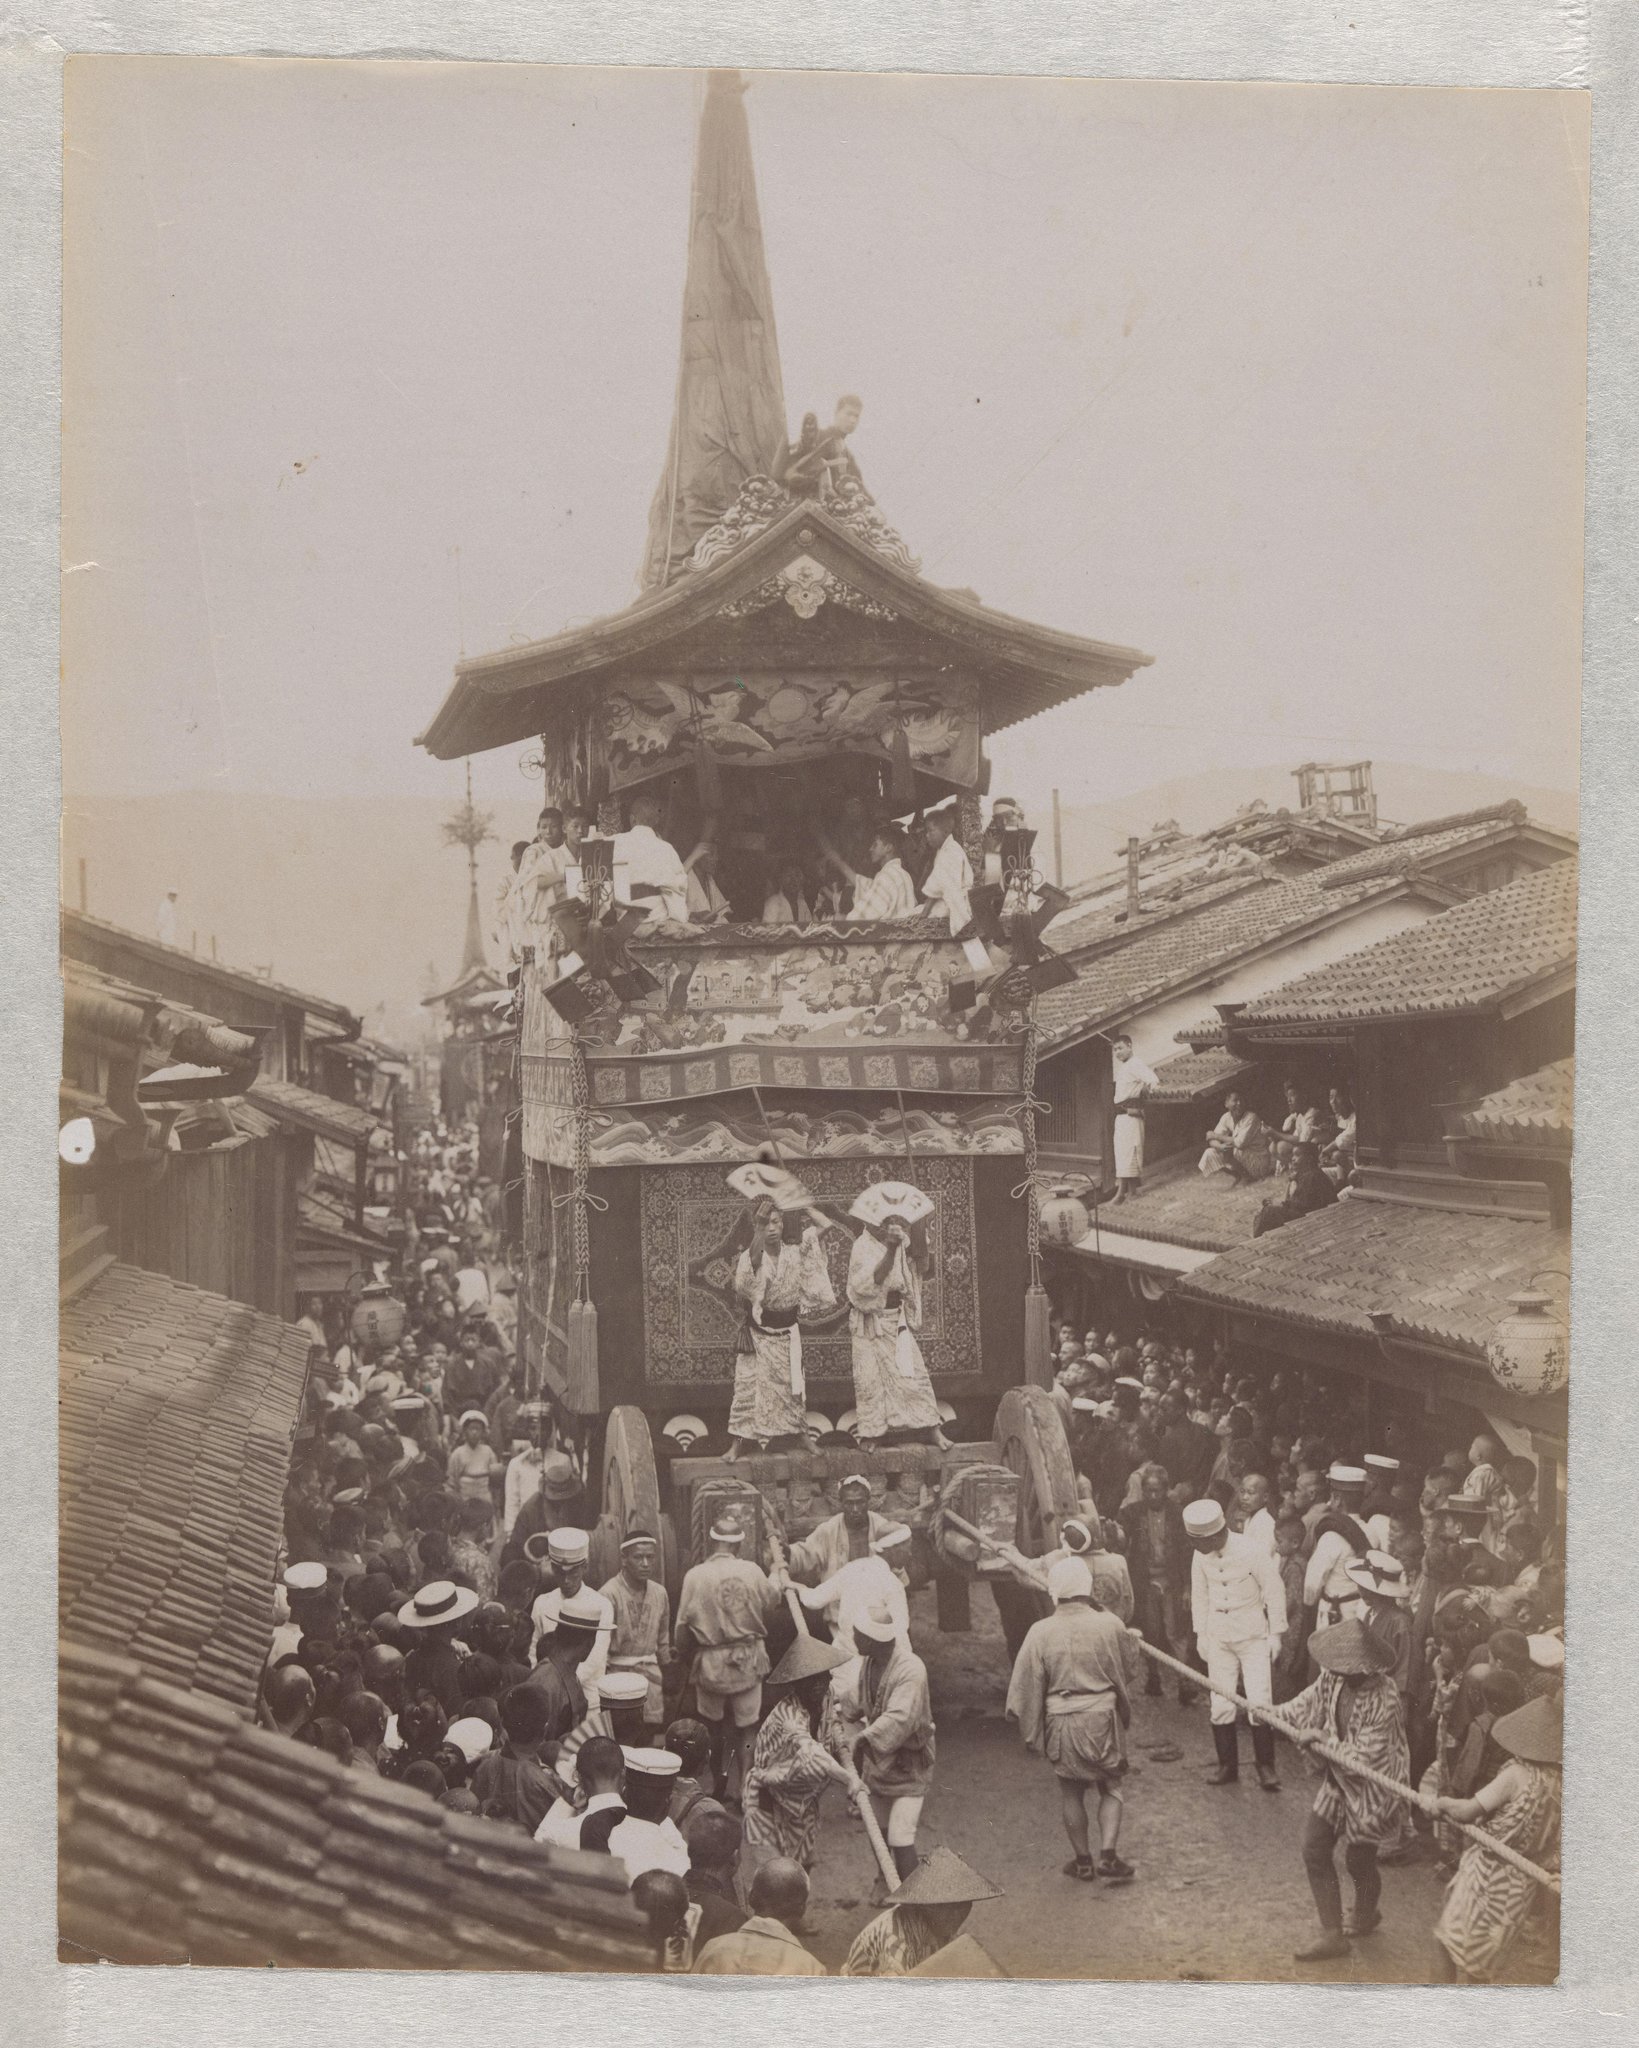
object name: photograph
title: Parade tijdens het Gion Matsuri in Kioto, Japan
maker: Anonymous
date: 1851-1900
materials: paper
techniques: albumen print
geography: kyoto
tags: festivities, kyoto